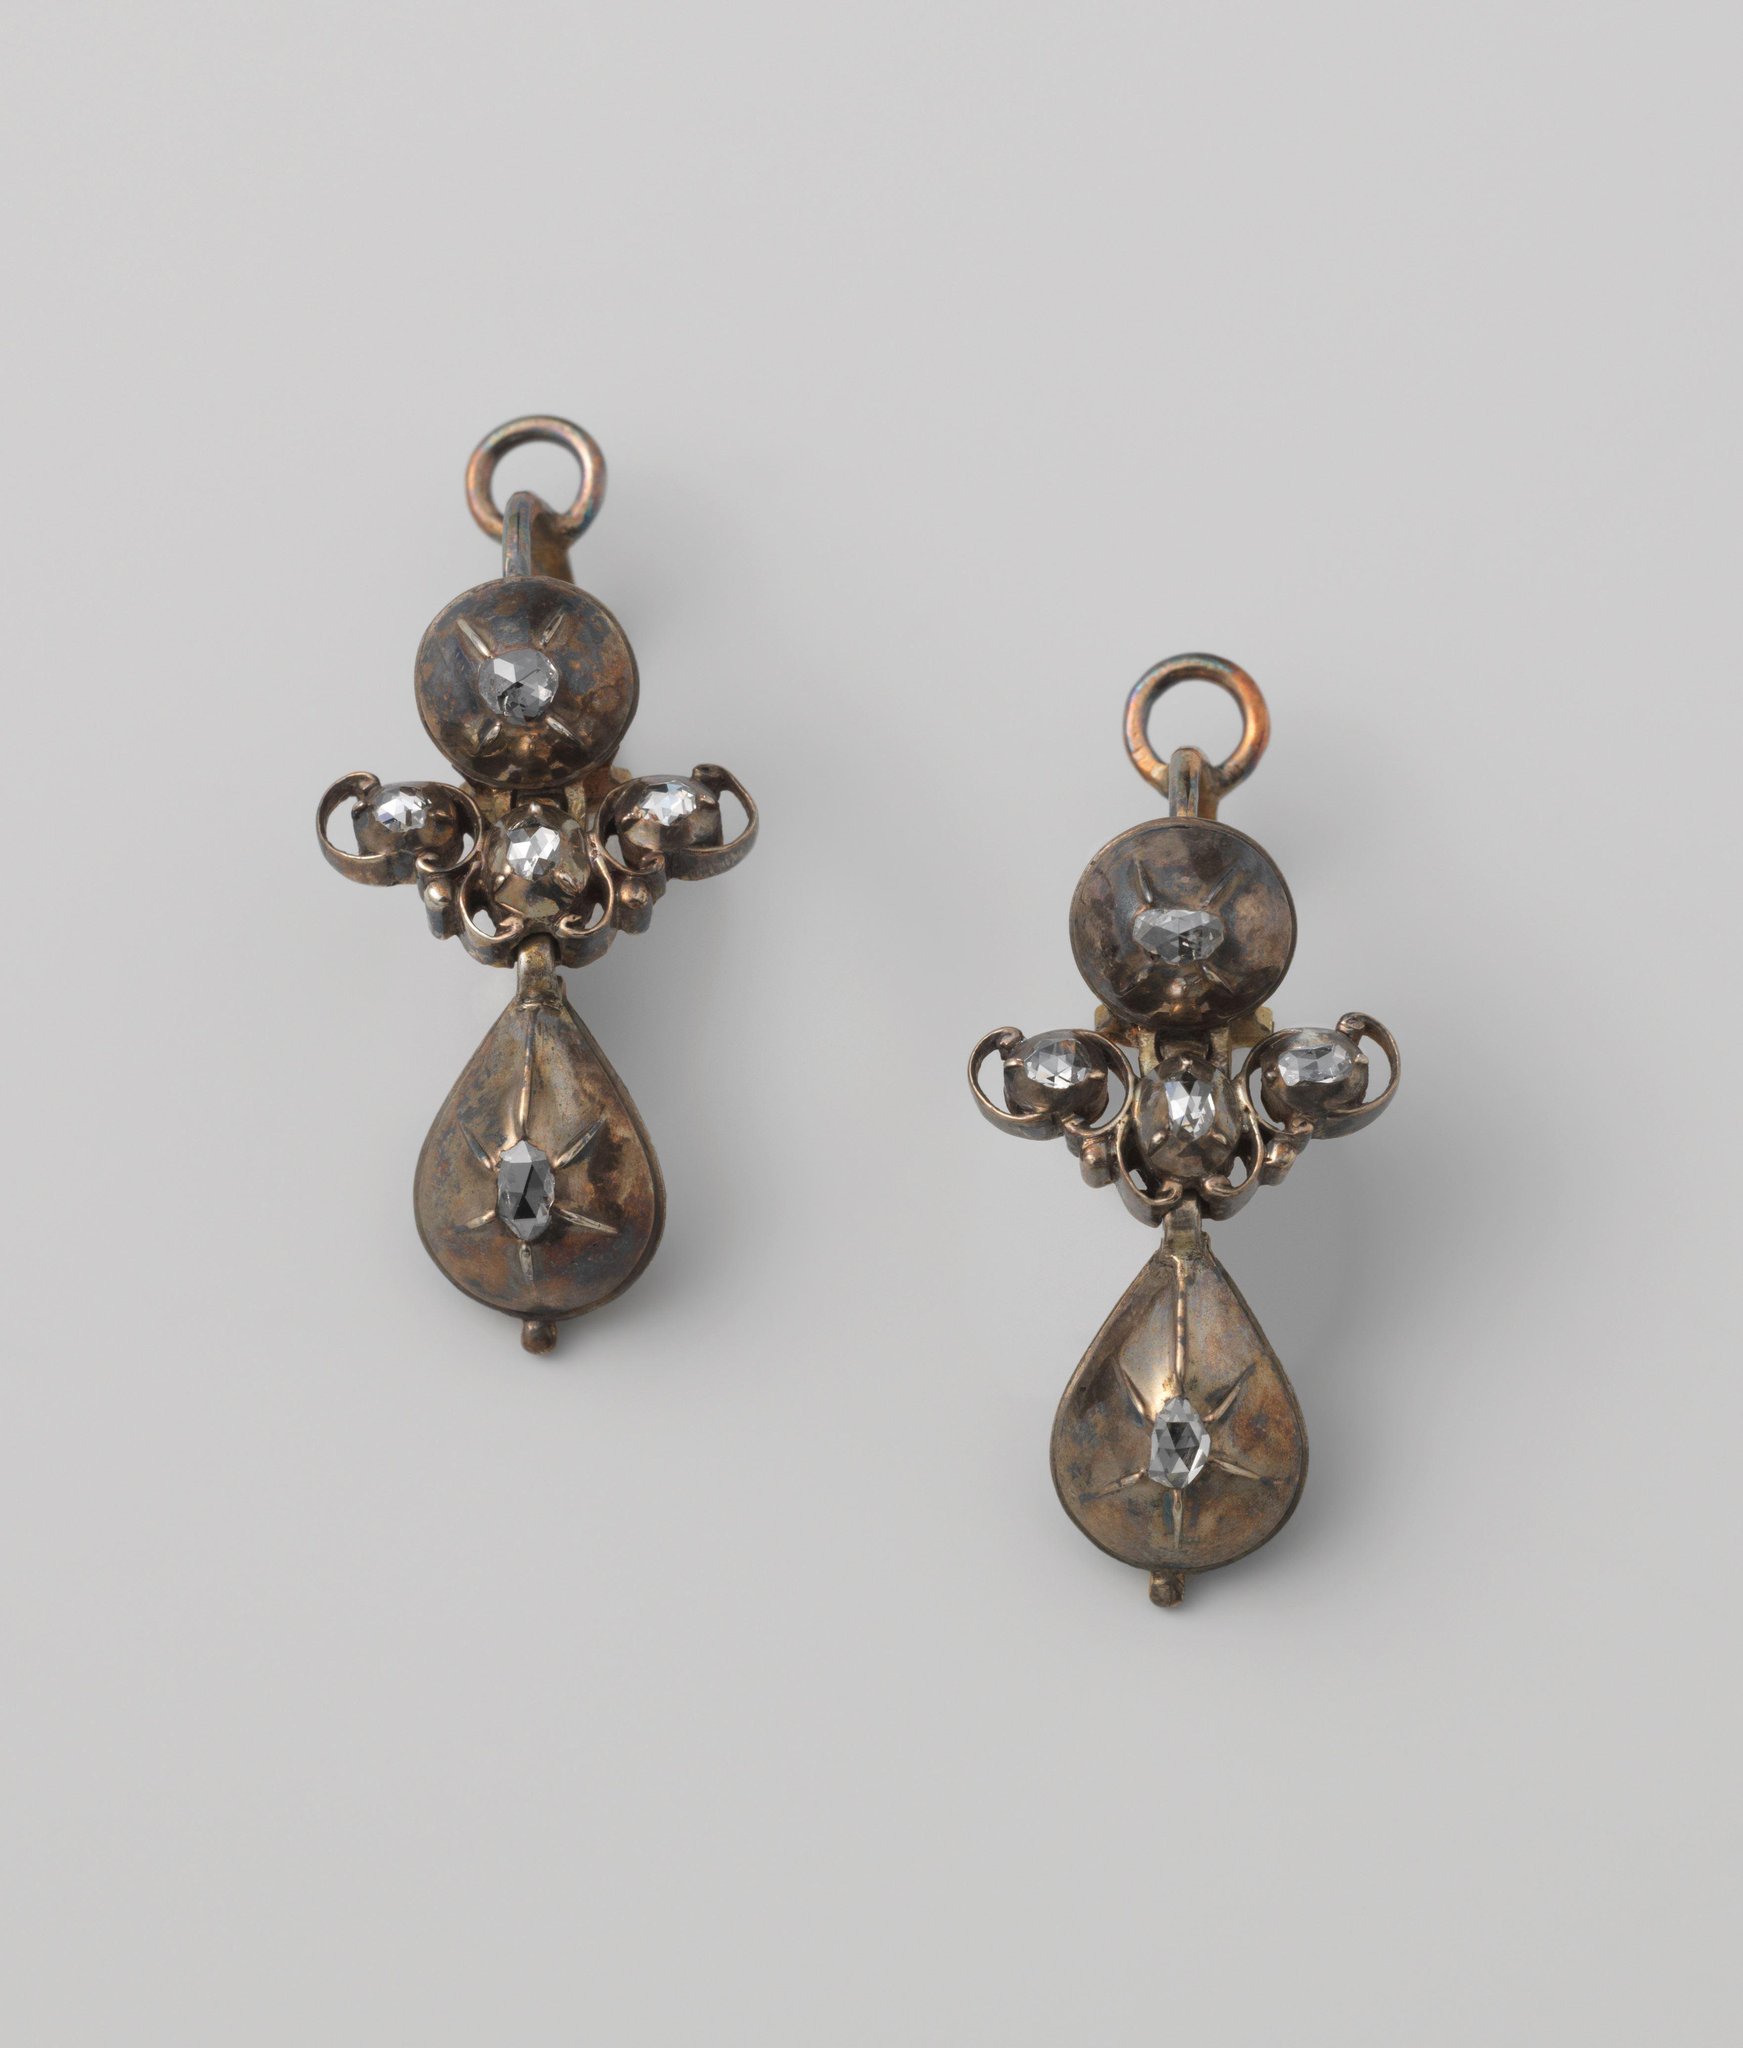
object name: jewellery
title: Paar zilveren oorhangers bezet met diamant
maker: Anonymous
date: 1750-1850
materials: diamond, silver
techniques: gilding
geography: netherlands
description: Een paar zilveren oorhangers, elk versierd met vijf roosgeslepen (Amsterdamse roos) diamanten. De achterzijde van de hangers is verguld, eveneens het scharnierende ringetje waarmee de oorhangers door het oor gestoken kunnen worden.